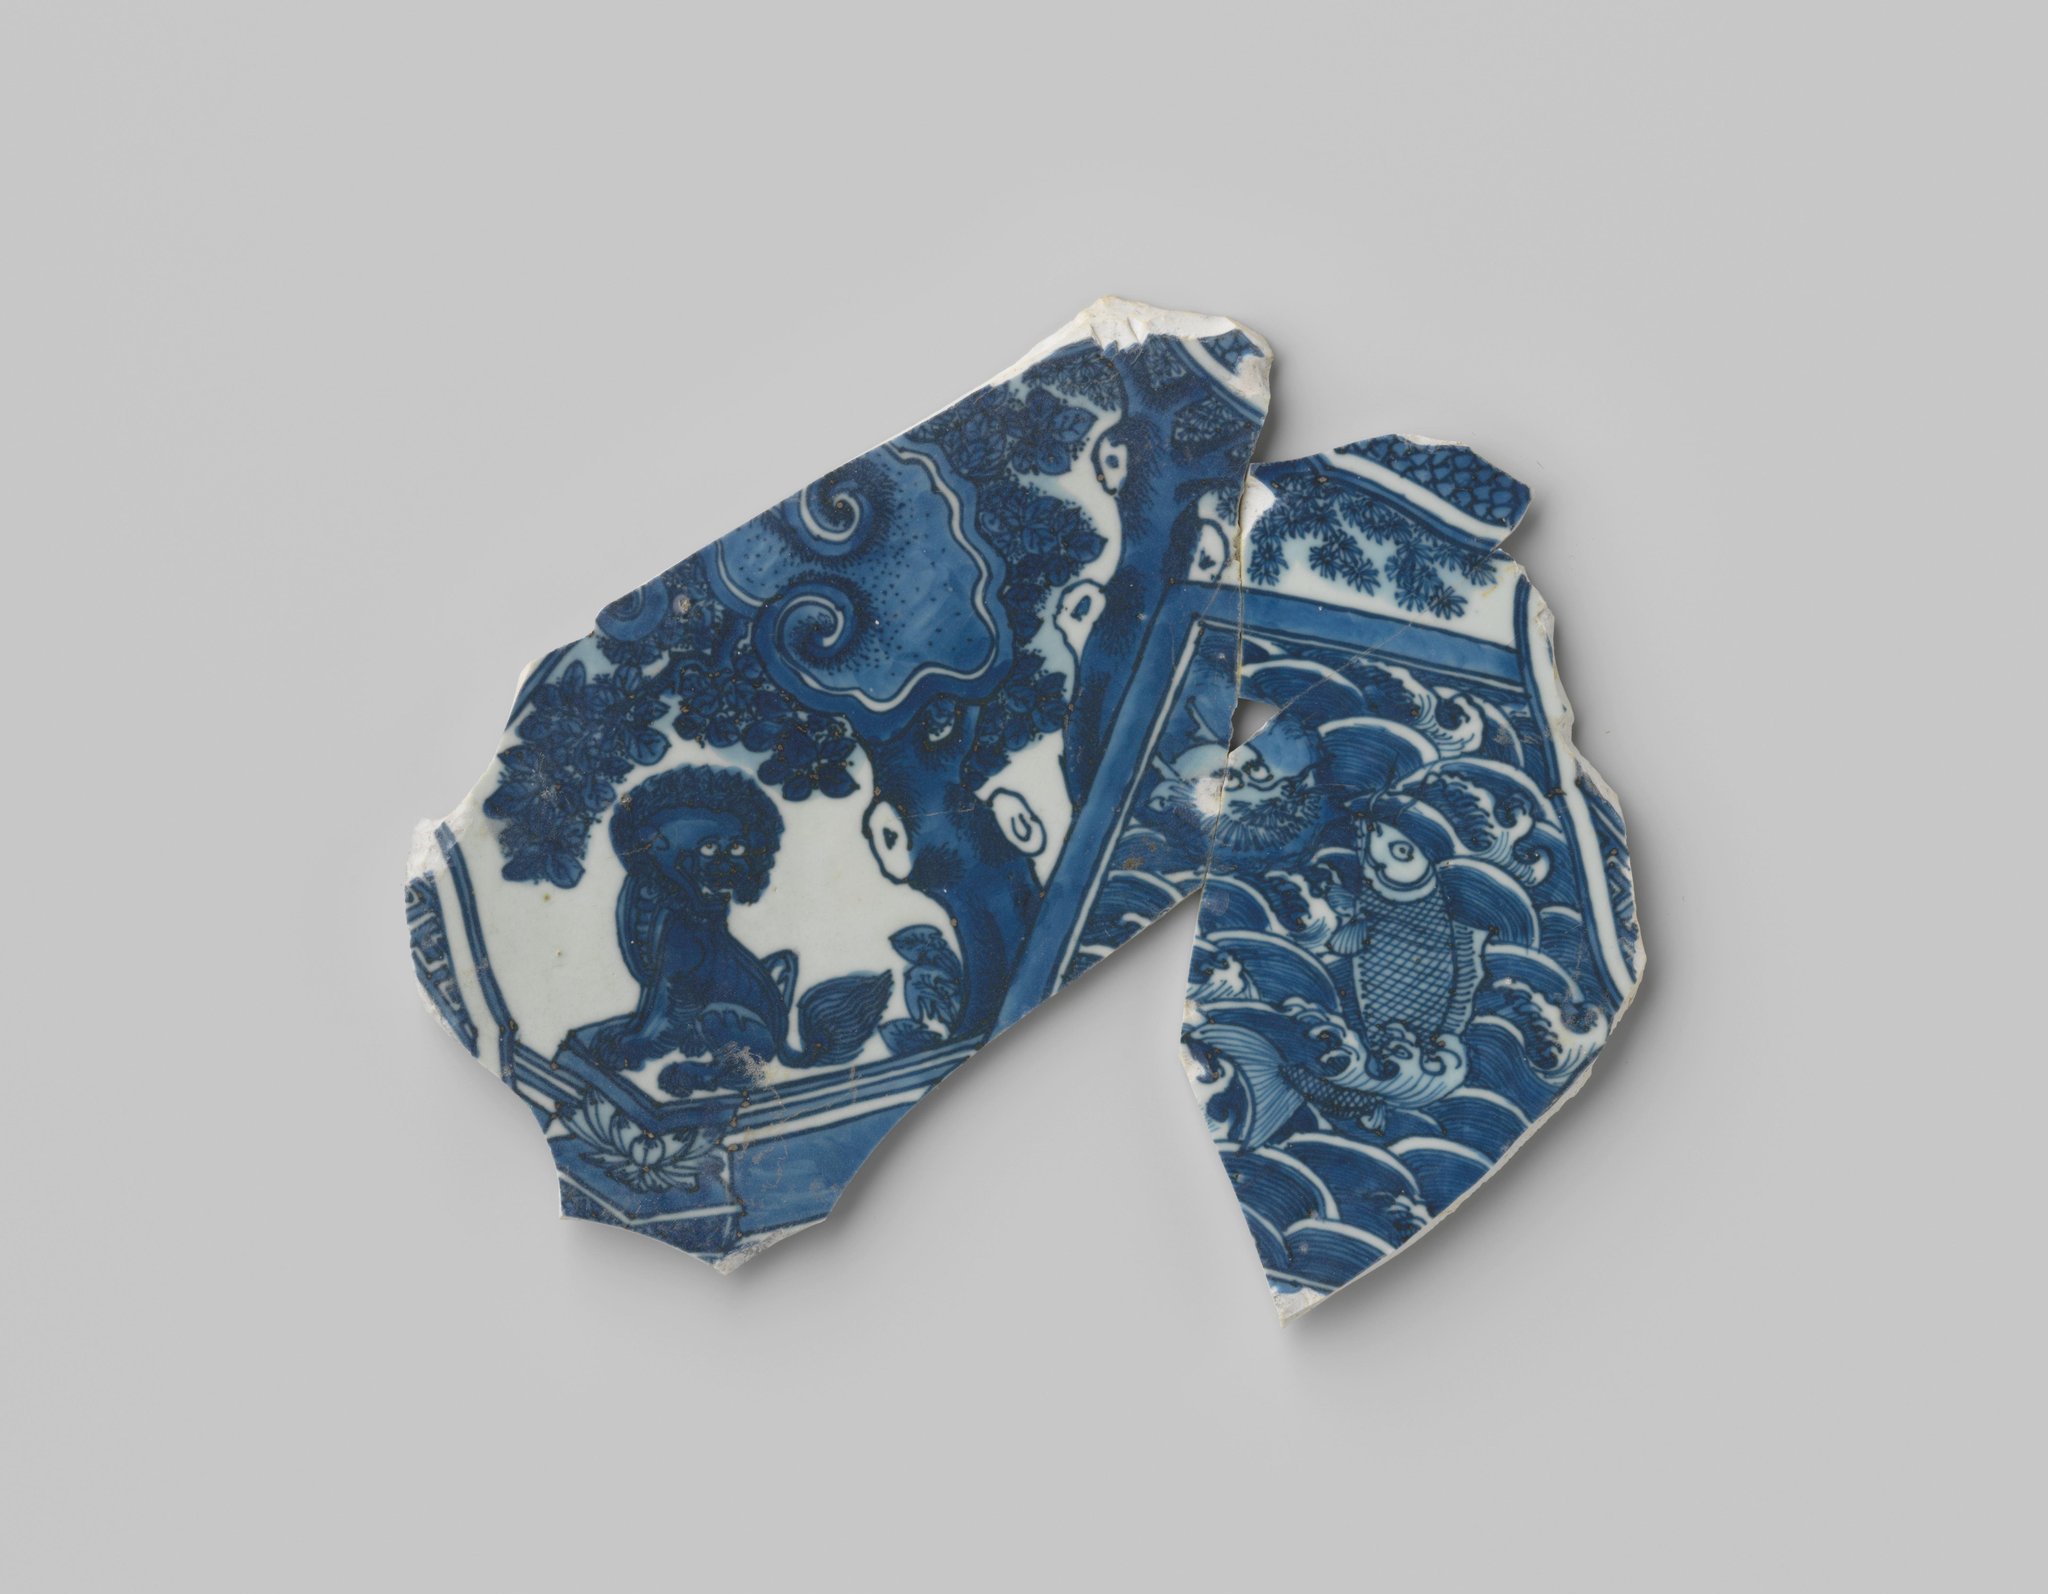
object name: washbowl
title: Fragment schotel uit V.O.C.-schip de 'Witte Leeuw'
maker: Anonymous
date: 1613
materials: bone china, glaze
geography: jingdezhen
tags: verenigde oostindische compagnie, sint-helena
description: Fragment schotel uit V.O.C.-schip de 'Witte Leeuw', 15% aanwezig. De scherf is glasachtig wit. Het glazuur is blauw getint en heeft pinholes en kleine bakscheurtjes op de hoeken van de liprand. De bodem is ongeglazuurd. De voetring is recht, gefacetteerd en staat naar binnen. Er is weinig ovenzand aangetroffen. Lampetschotel. Drie aan elkaar gelijmde scherven.